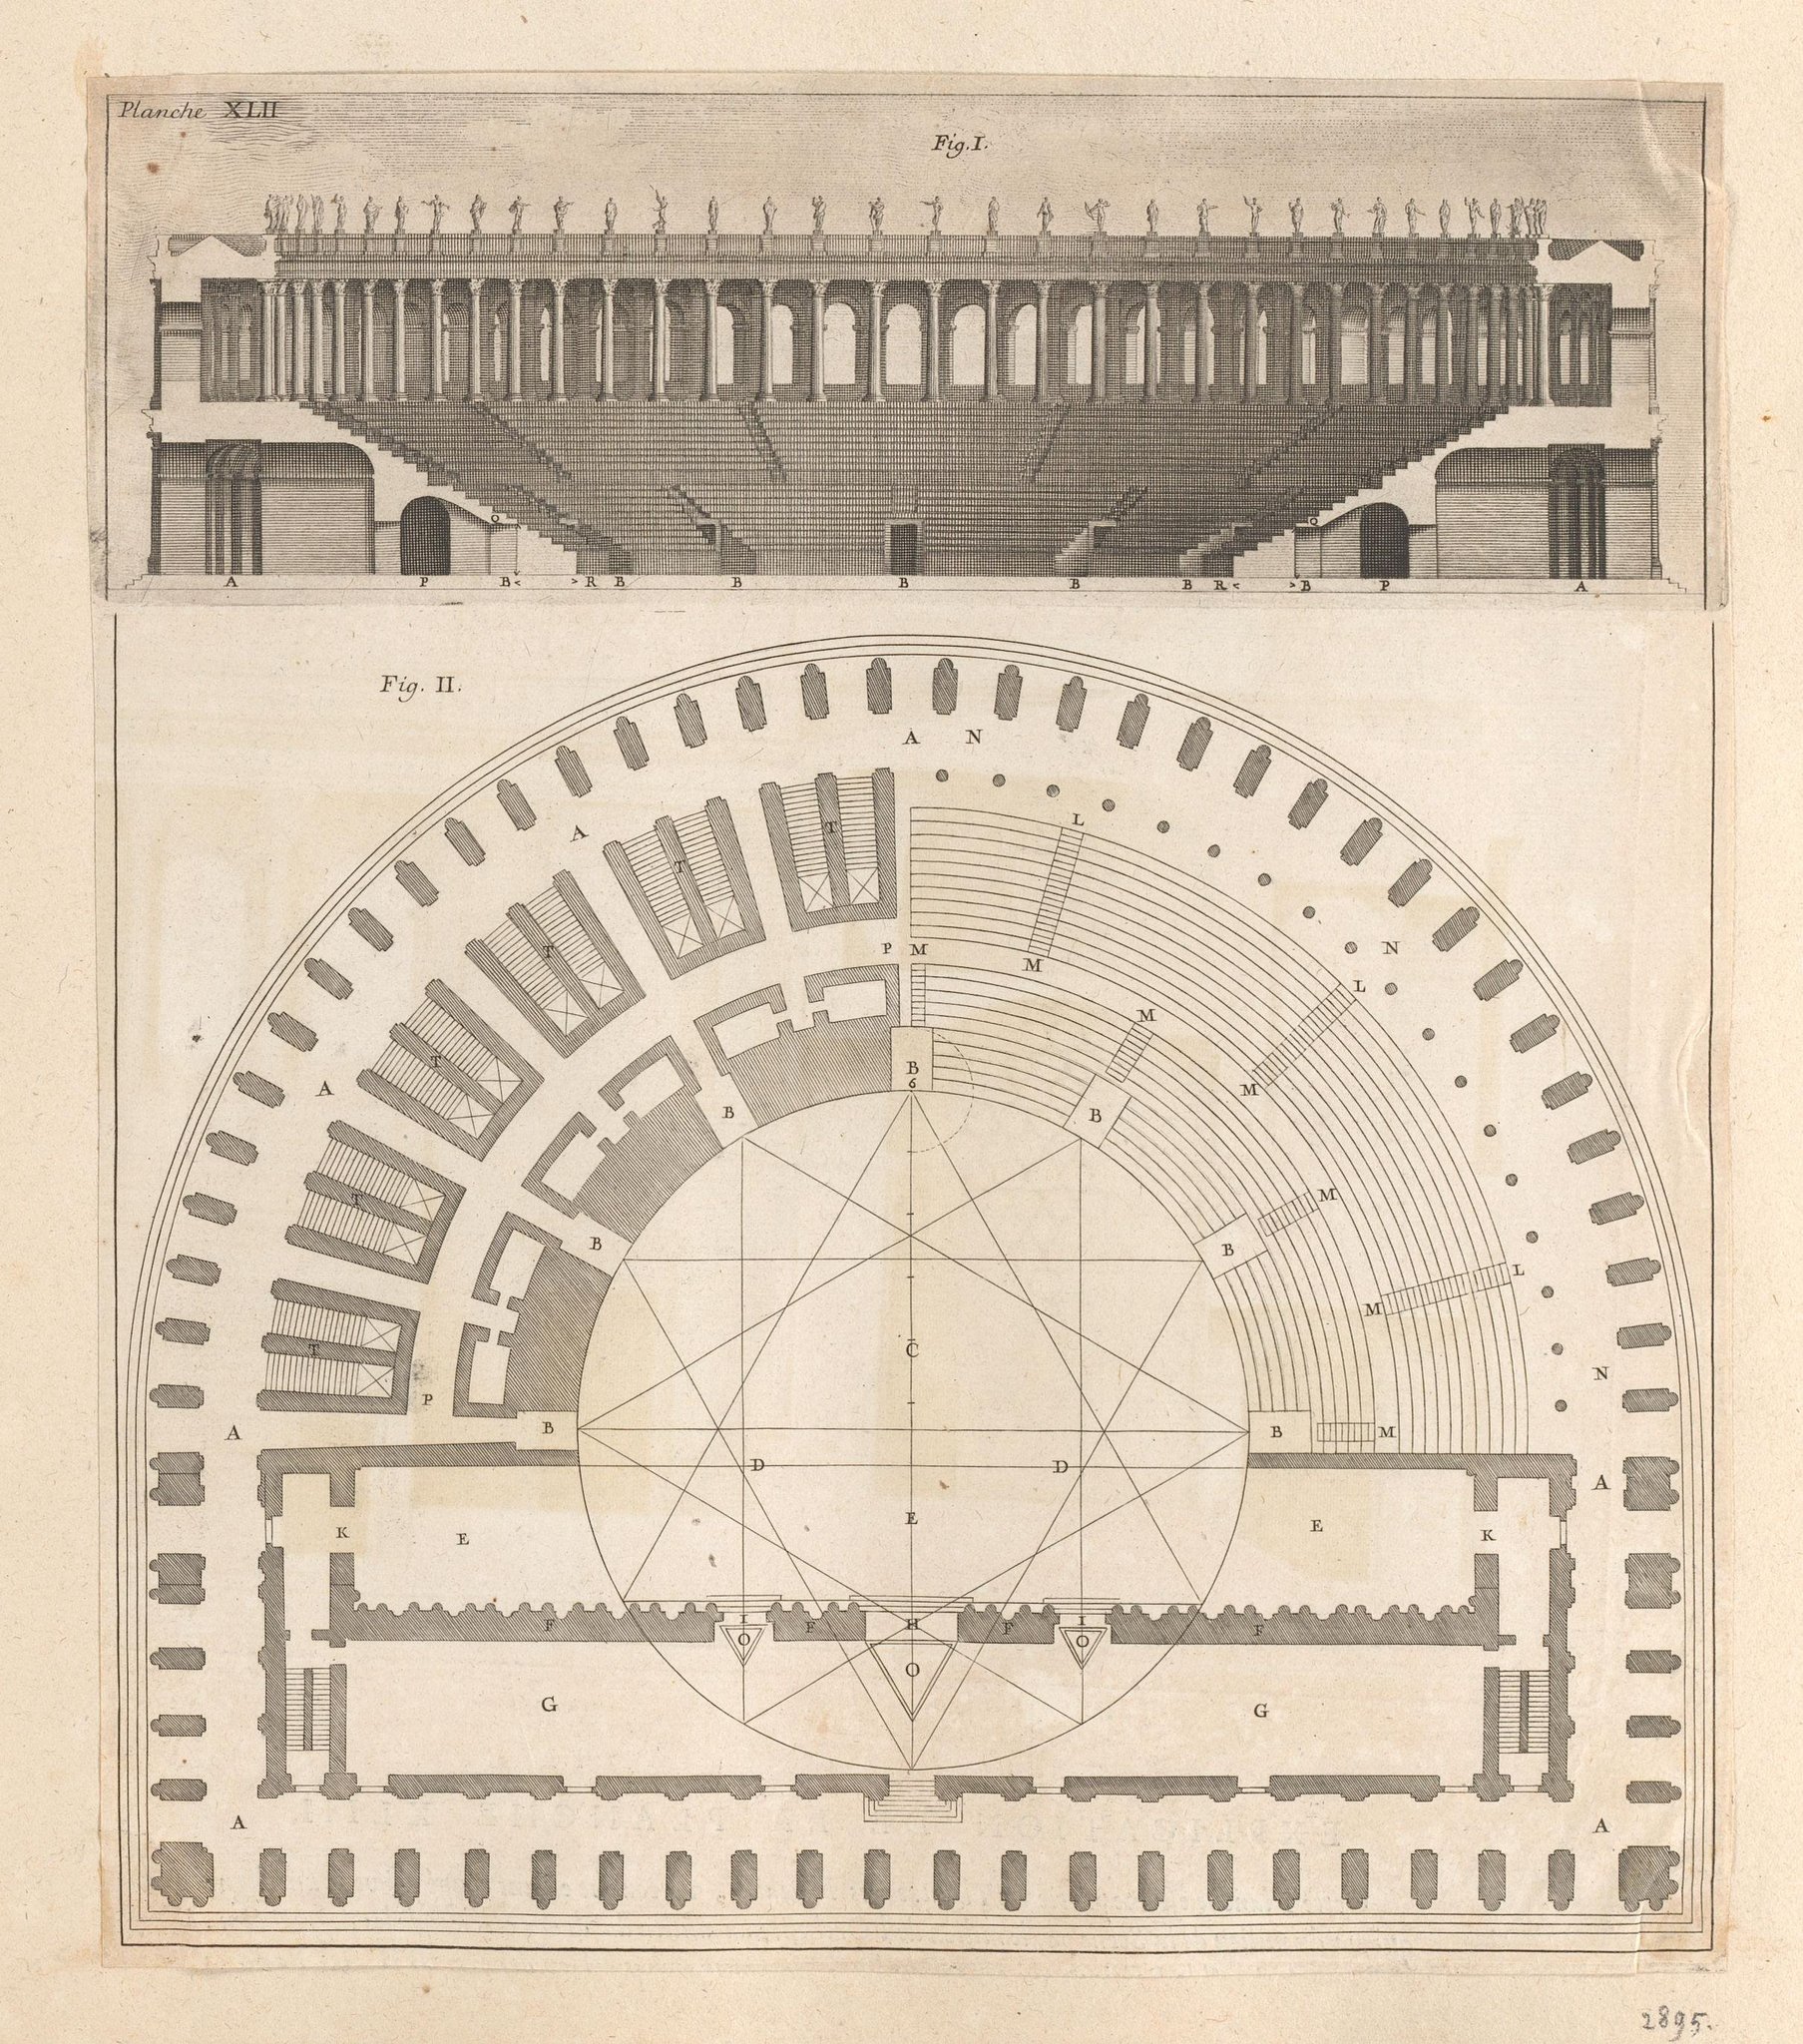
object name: print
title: Planche XLII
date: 1673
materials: paper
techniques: engraving, etching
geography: paris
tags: amphitheatre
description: Prent uit: Perrault, Claude. Les dix livres d'architecture de Vitruve. Parijs: Jean-Baptiste Coignard, 1673.